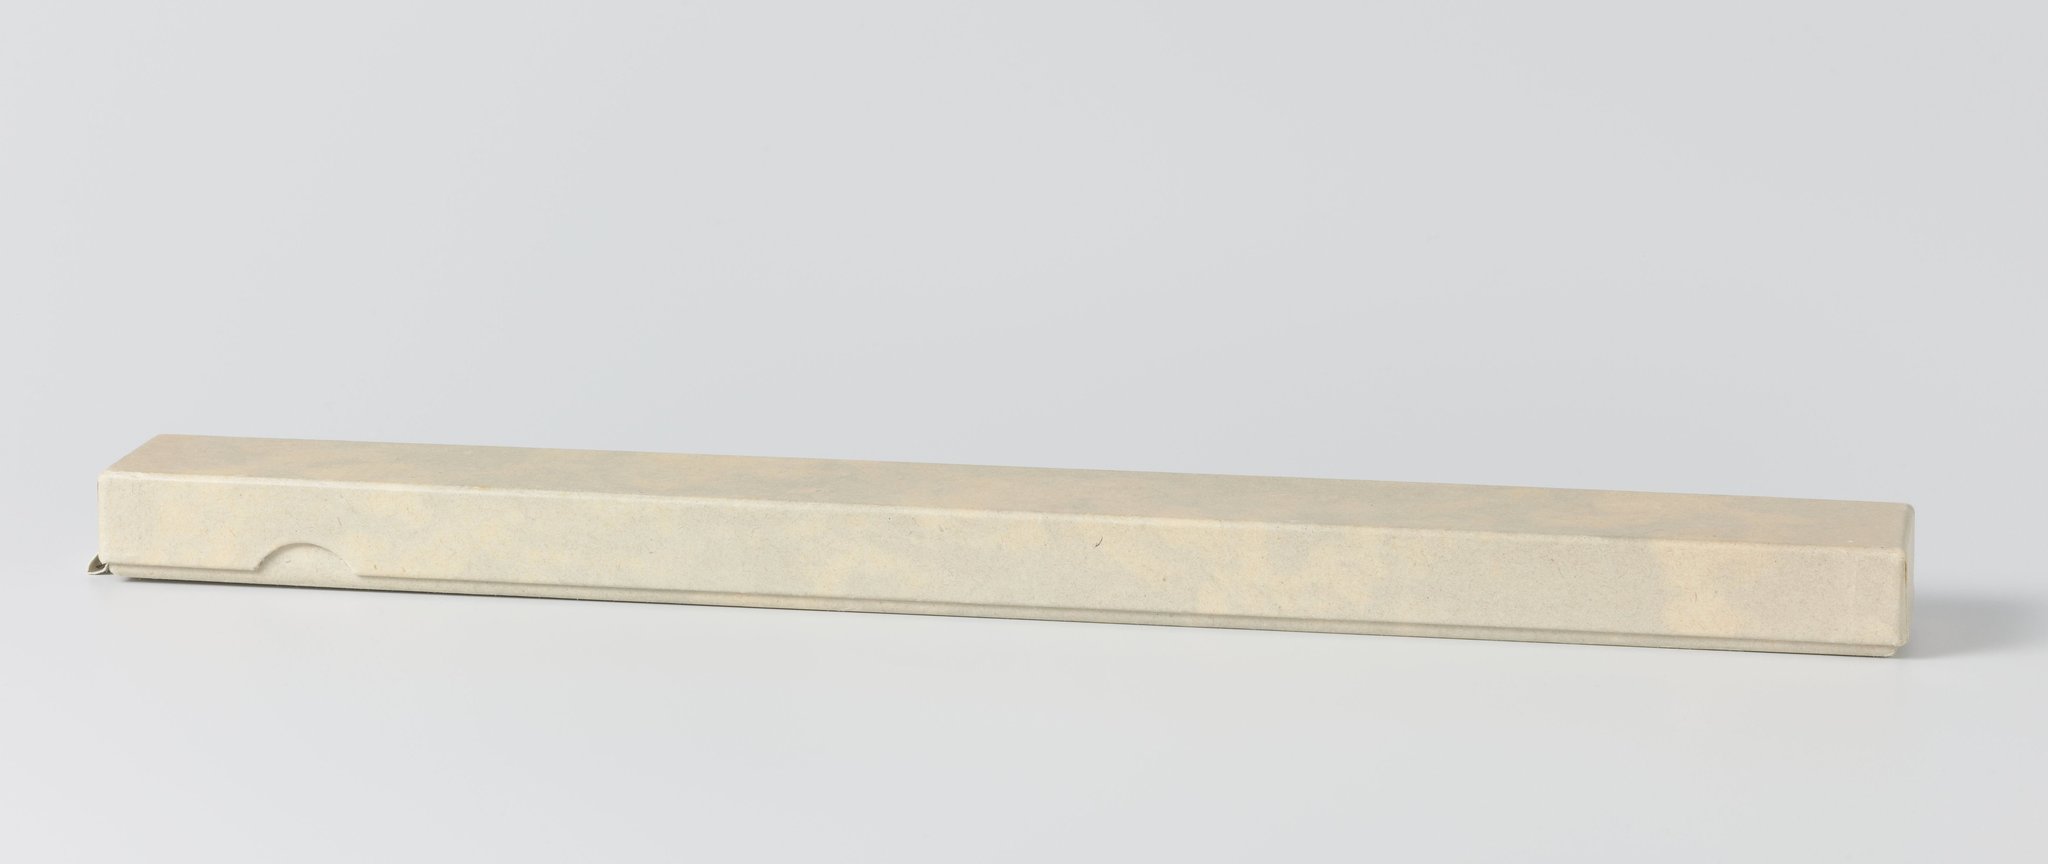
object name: packing material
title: Waaierdoos van karton beplakt met grijs/beige gewaterd papier en gevoerd met gespikkeld beige papier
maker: Anonymous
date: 1897-1919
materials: cardboard, paper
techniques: watermarked, pasting, scooping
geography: netherlands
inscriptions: dedication: ‘C.I. Six, souvenir van Oom Willem Six (1859-1919)/ afkomstig van zijn moeder C. Six-teding v. Berkhout’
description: Waaierdoos van karton beplakt met grijs/beige gewaterd papier en gevoerd met gespikkeld beige papier.